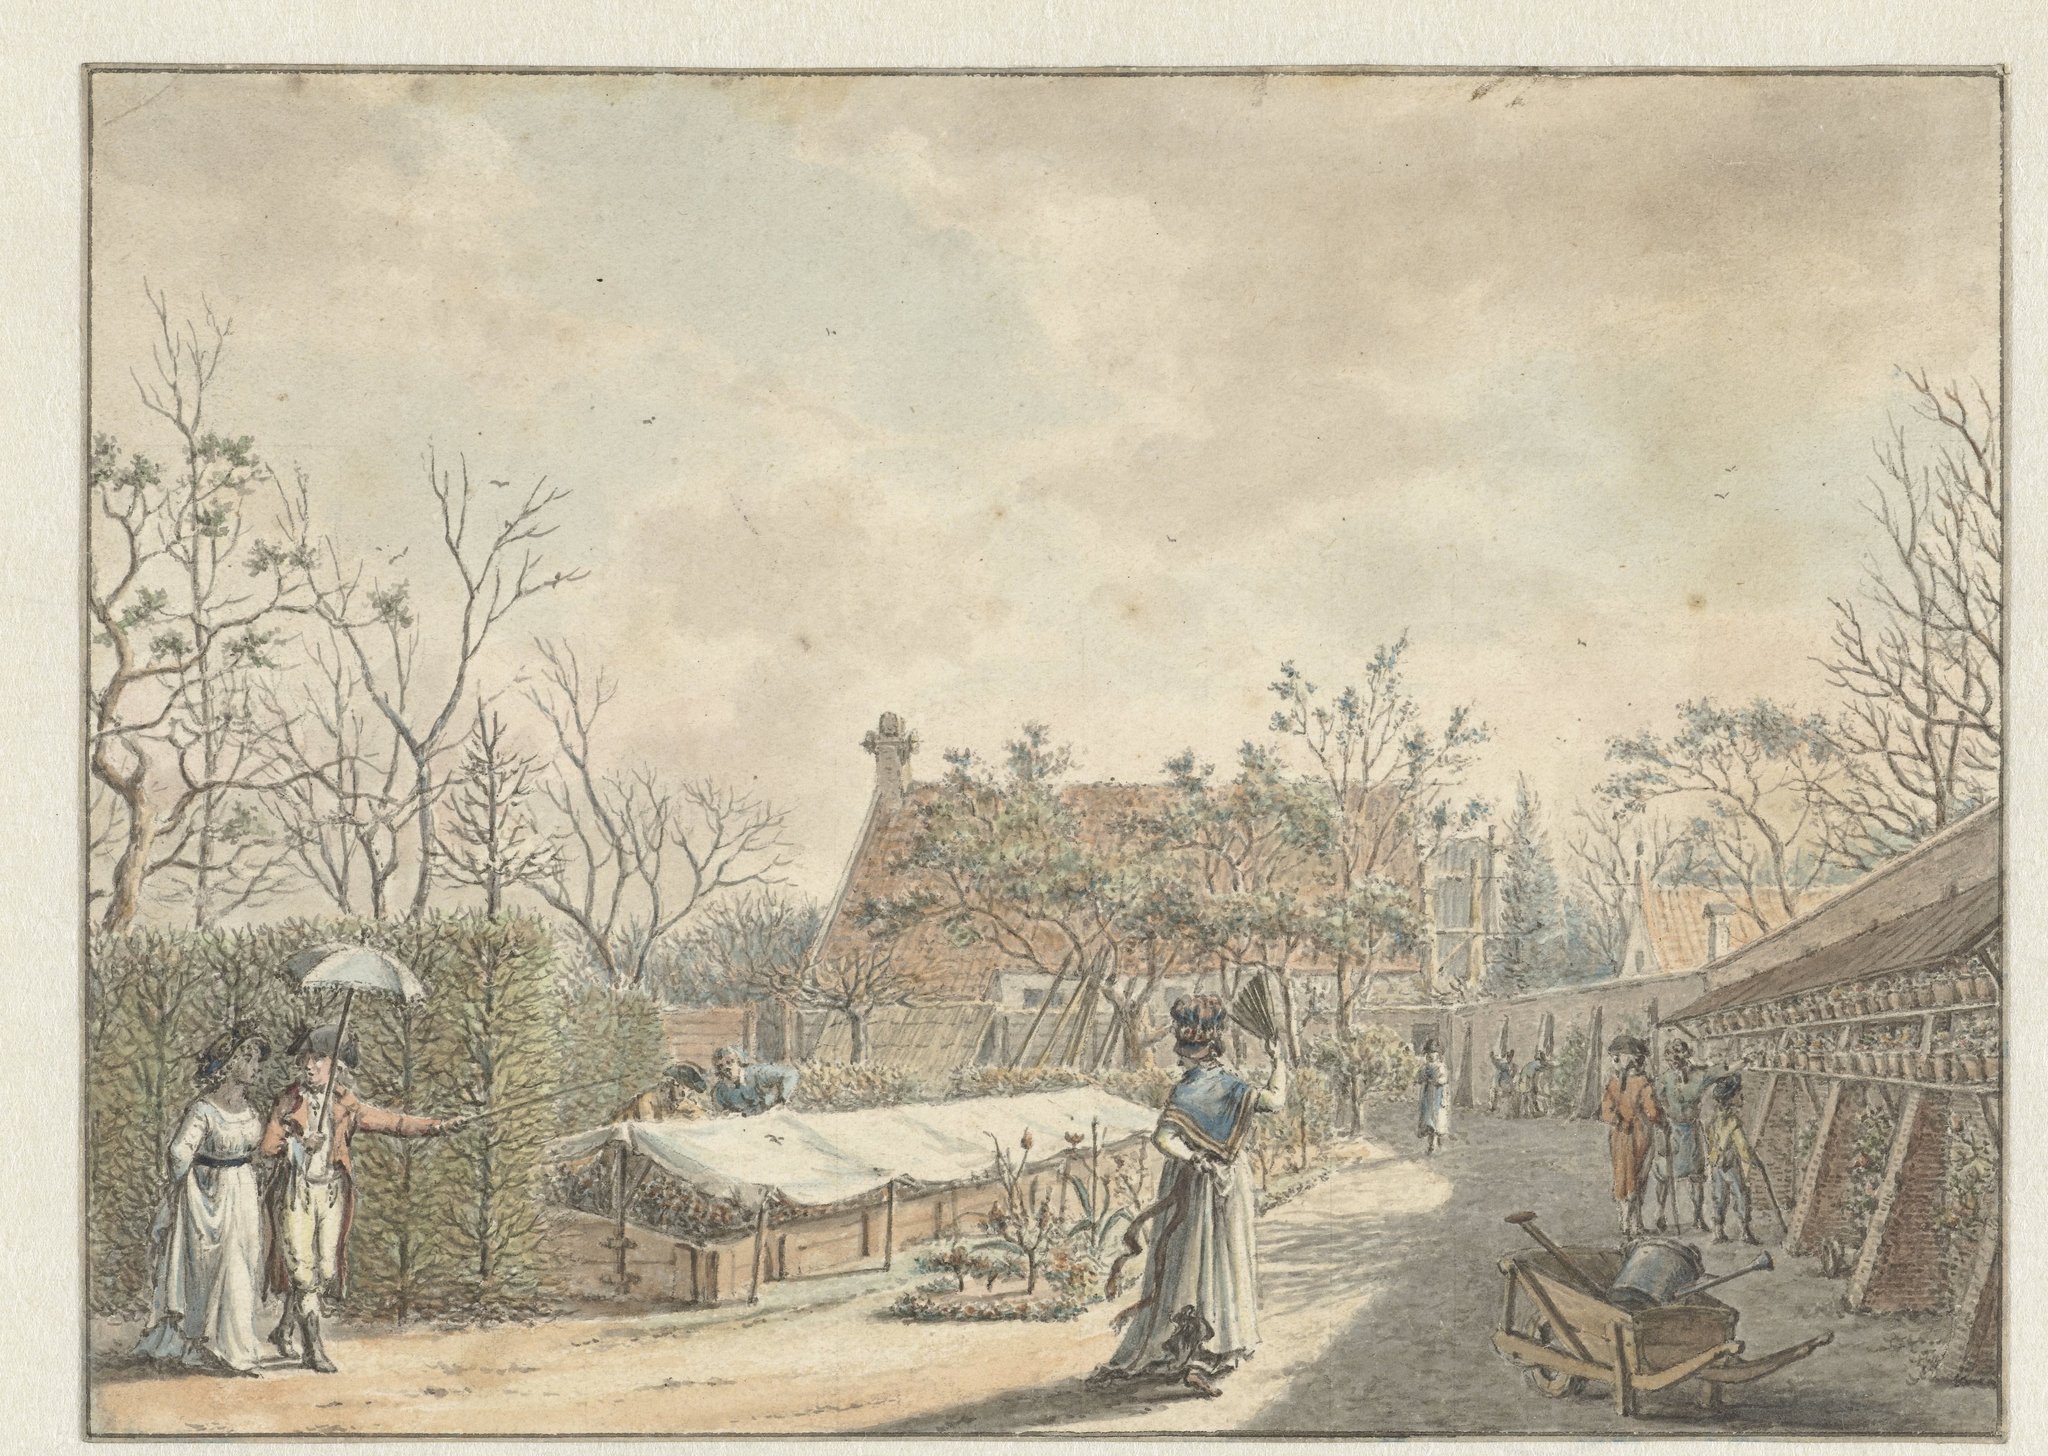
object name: drawing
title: Visit to a Flower Nursery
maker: jacob cats (1741-1799)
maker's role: draughtsman, print maker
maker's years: 1741-1799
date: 1791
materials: paper, watercolor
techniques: brush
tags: landscape symbolizing april, flower nursery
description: In the 18th century a visit to a flower nursery was a popular spring outing. Fashionably attired ladies and gentlemen here stroll past seed boxes and racks with potted plants. People from Amsterdam, Leiden, and The Hague all came for this purpose to Haarlem, the centre of floristry. This drawing is an illustration of the month of April from a series of the Twelve Months.